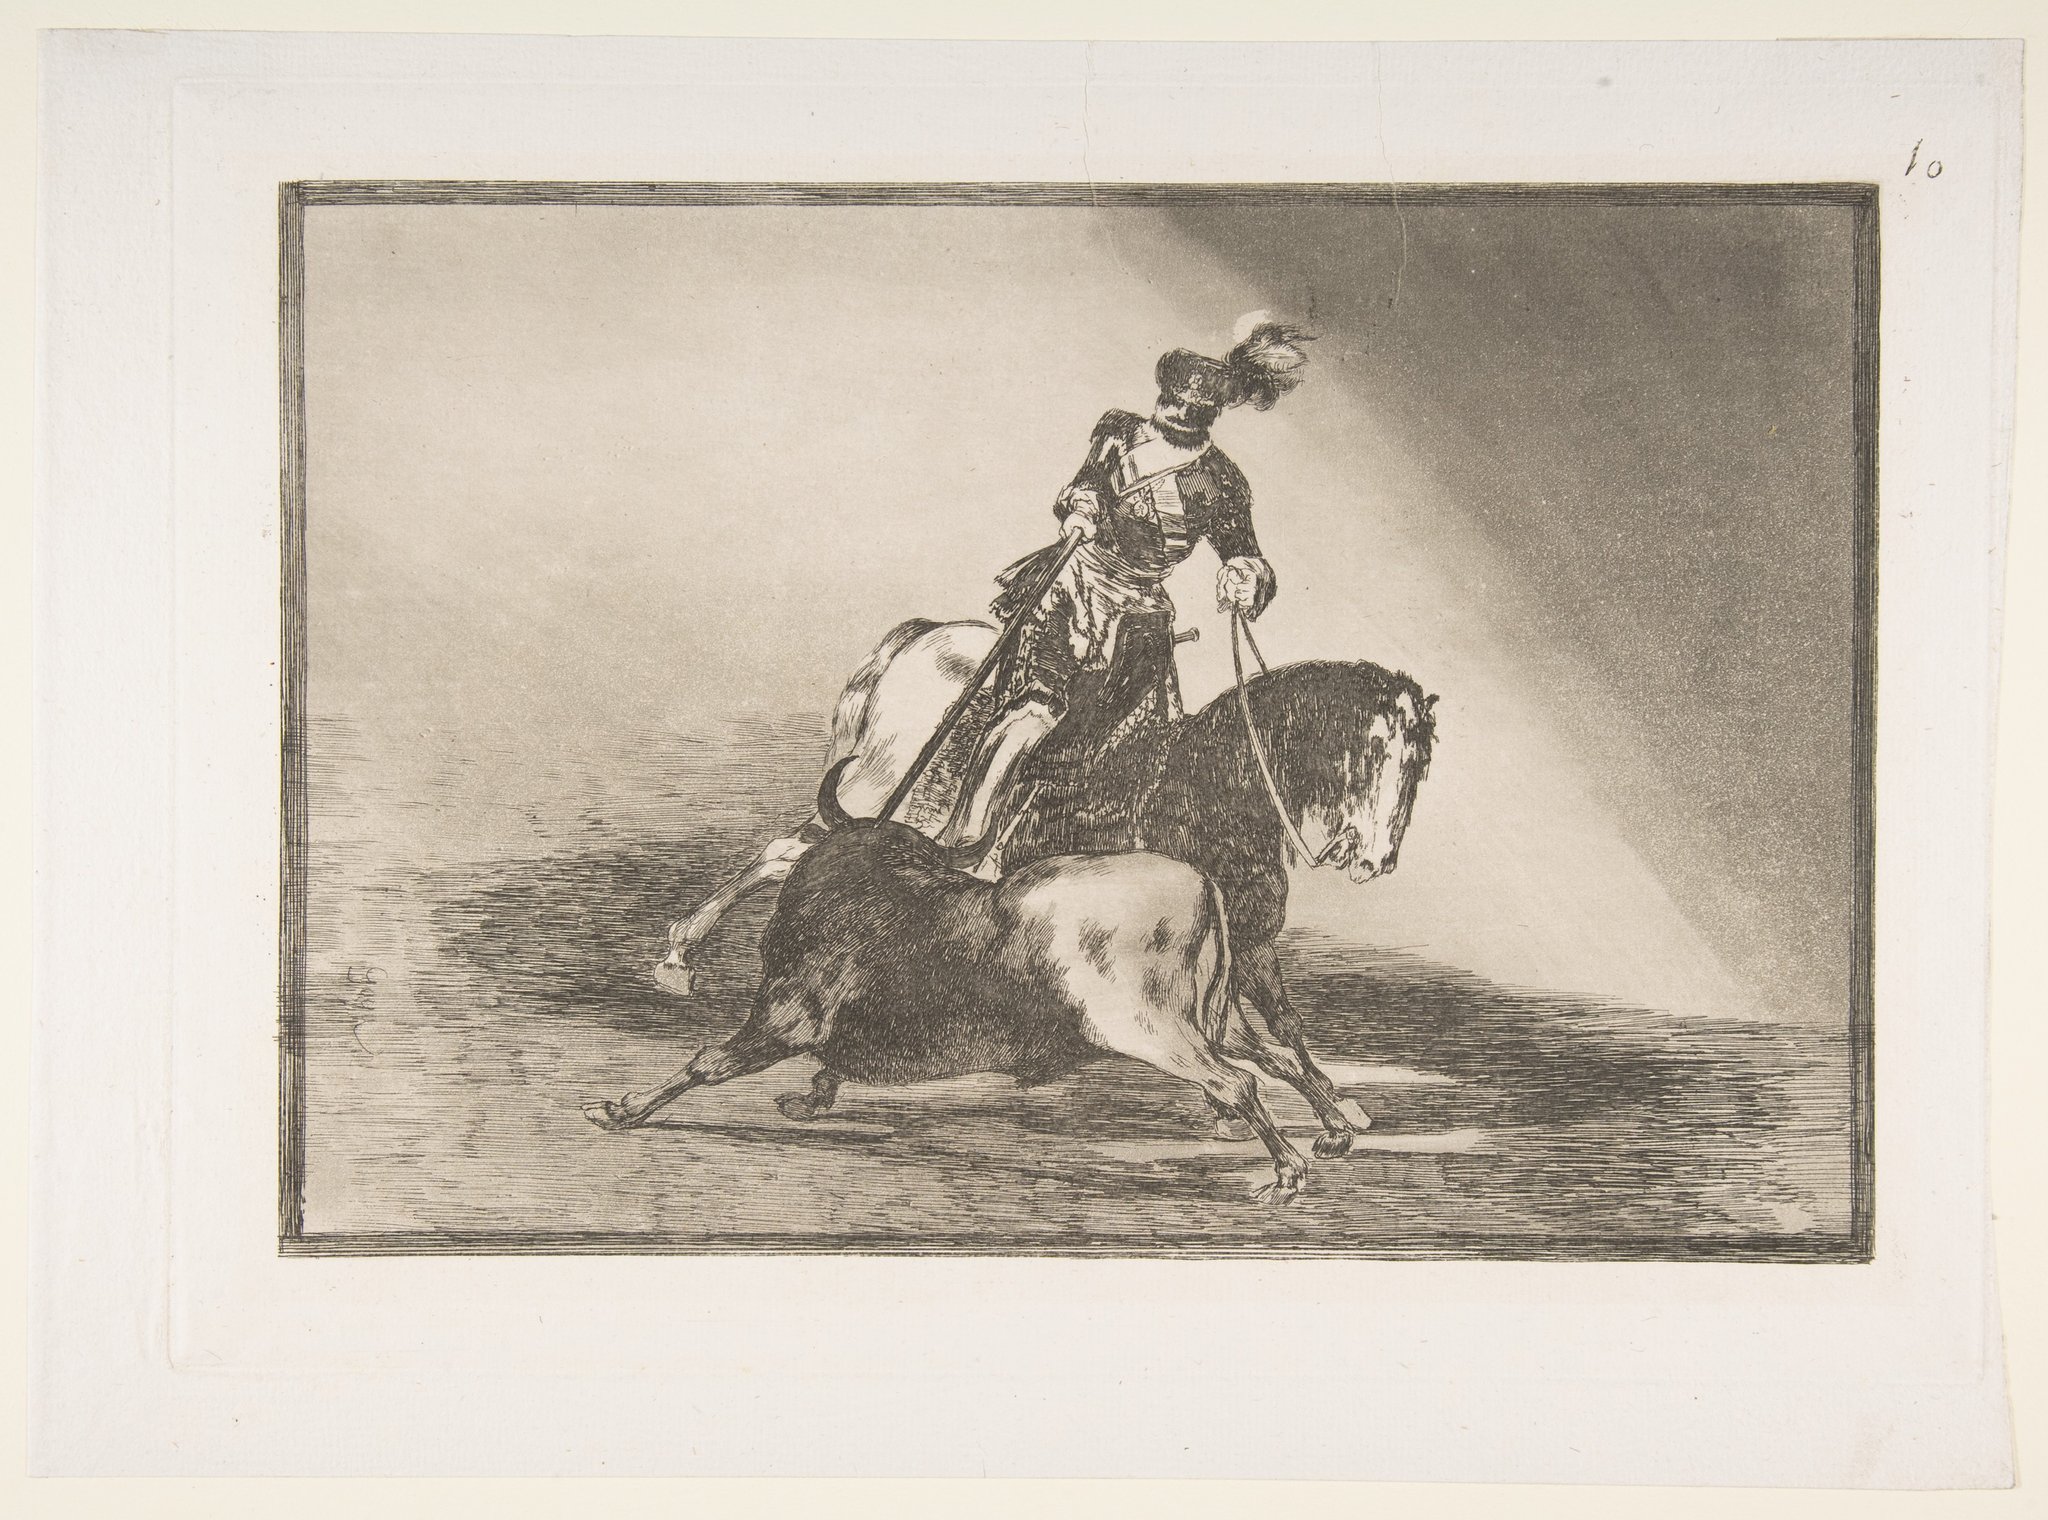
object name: print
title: Charles V spearing a bull in the ring at Valladolid, plate 10 from "La Tauromaquia"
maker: goya (francisco de goya y lucientes)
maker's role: artist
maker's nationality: spanish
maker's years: 1746-1828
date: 1816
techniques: aquatint, engraving, burnishing, drypoint, etching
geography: spain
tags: men,bulls